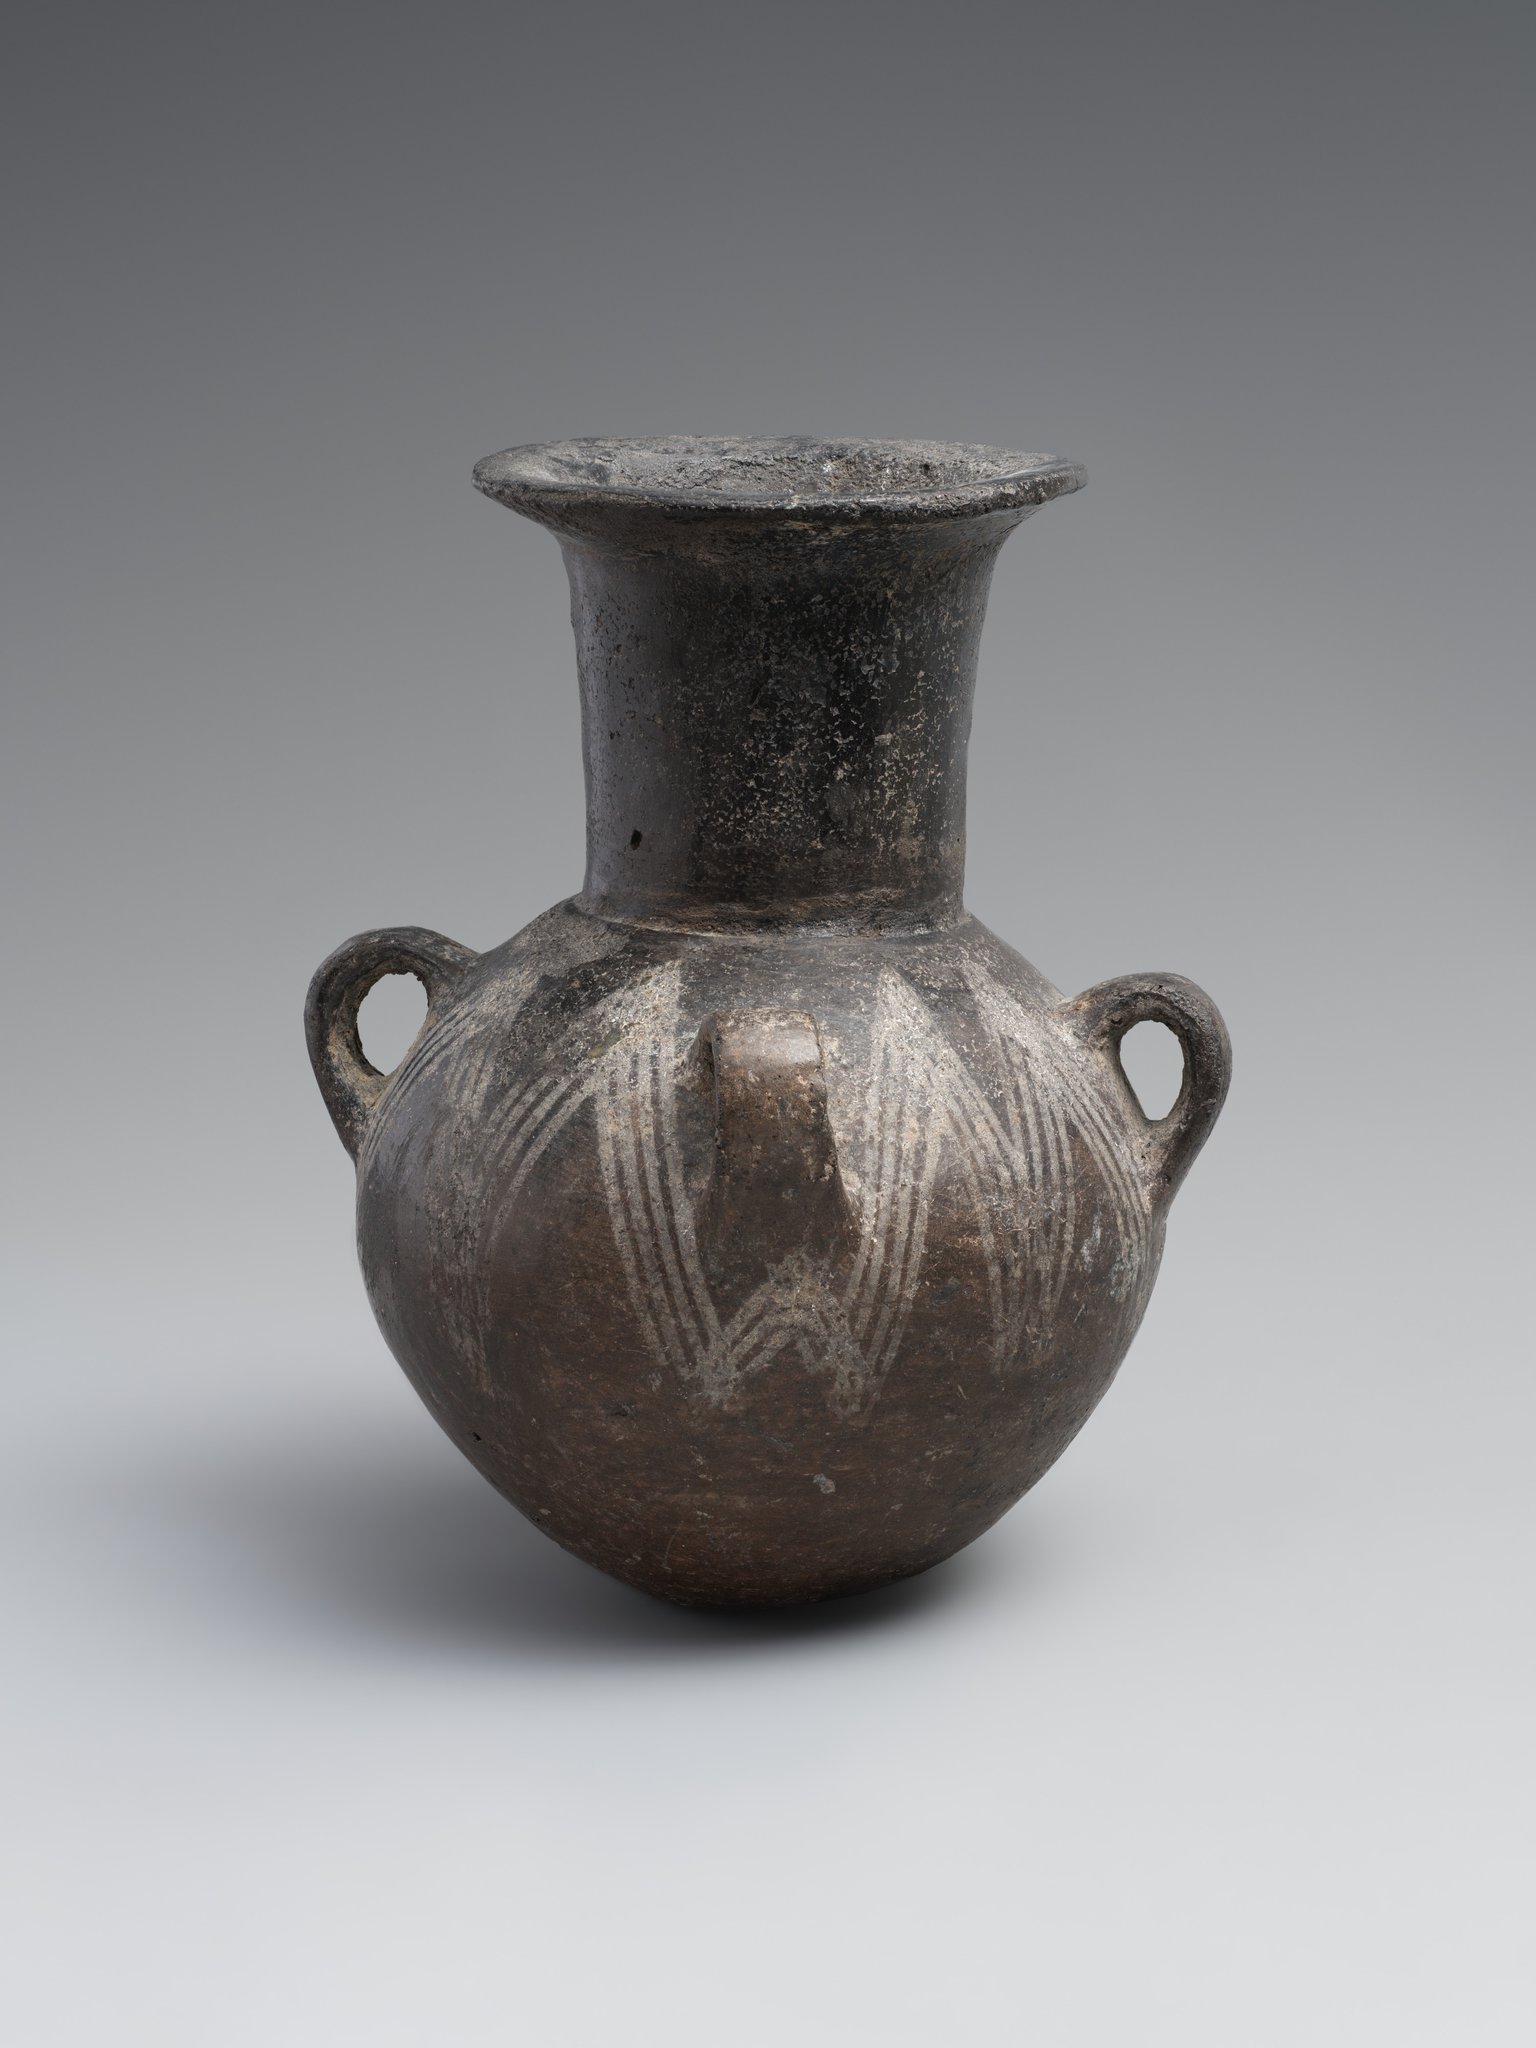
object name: jar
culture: yortan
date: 2700-2400 BCE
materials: ceramic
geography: northwestern anatolia